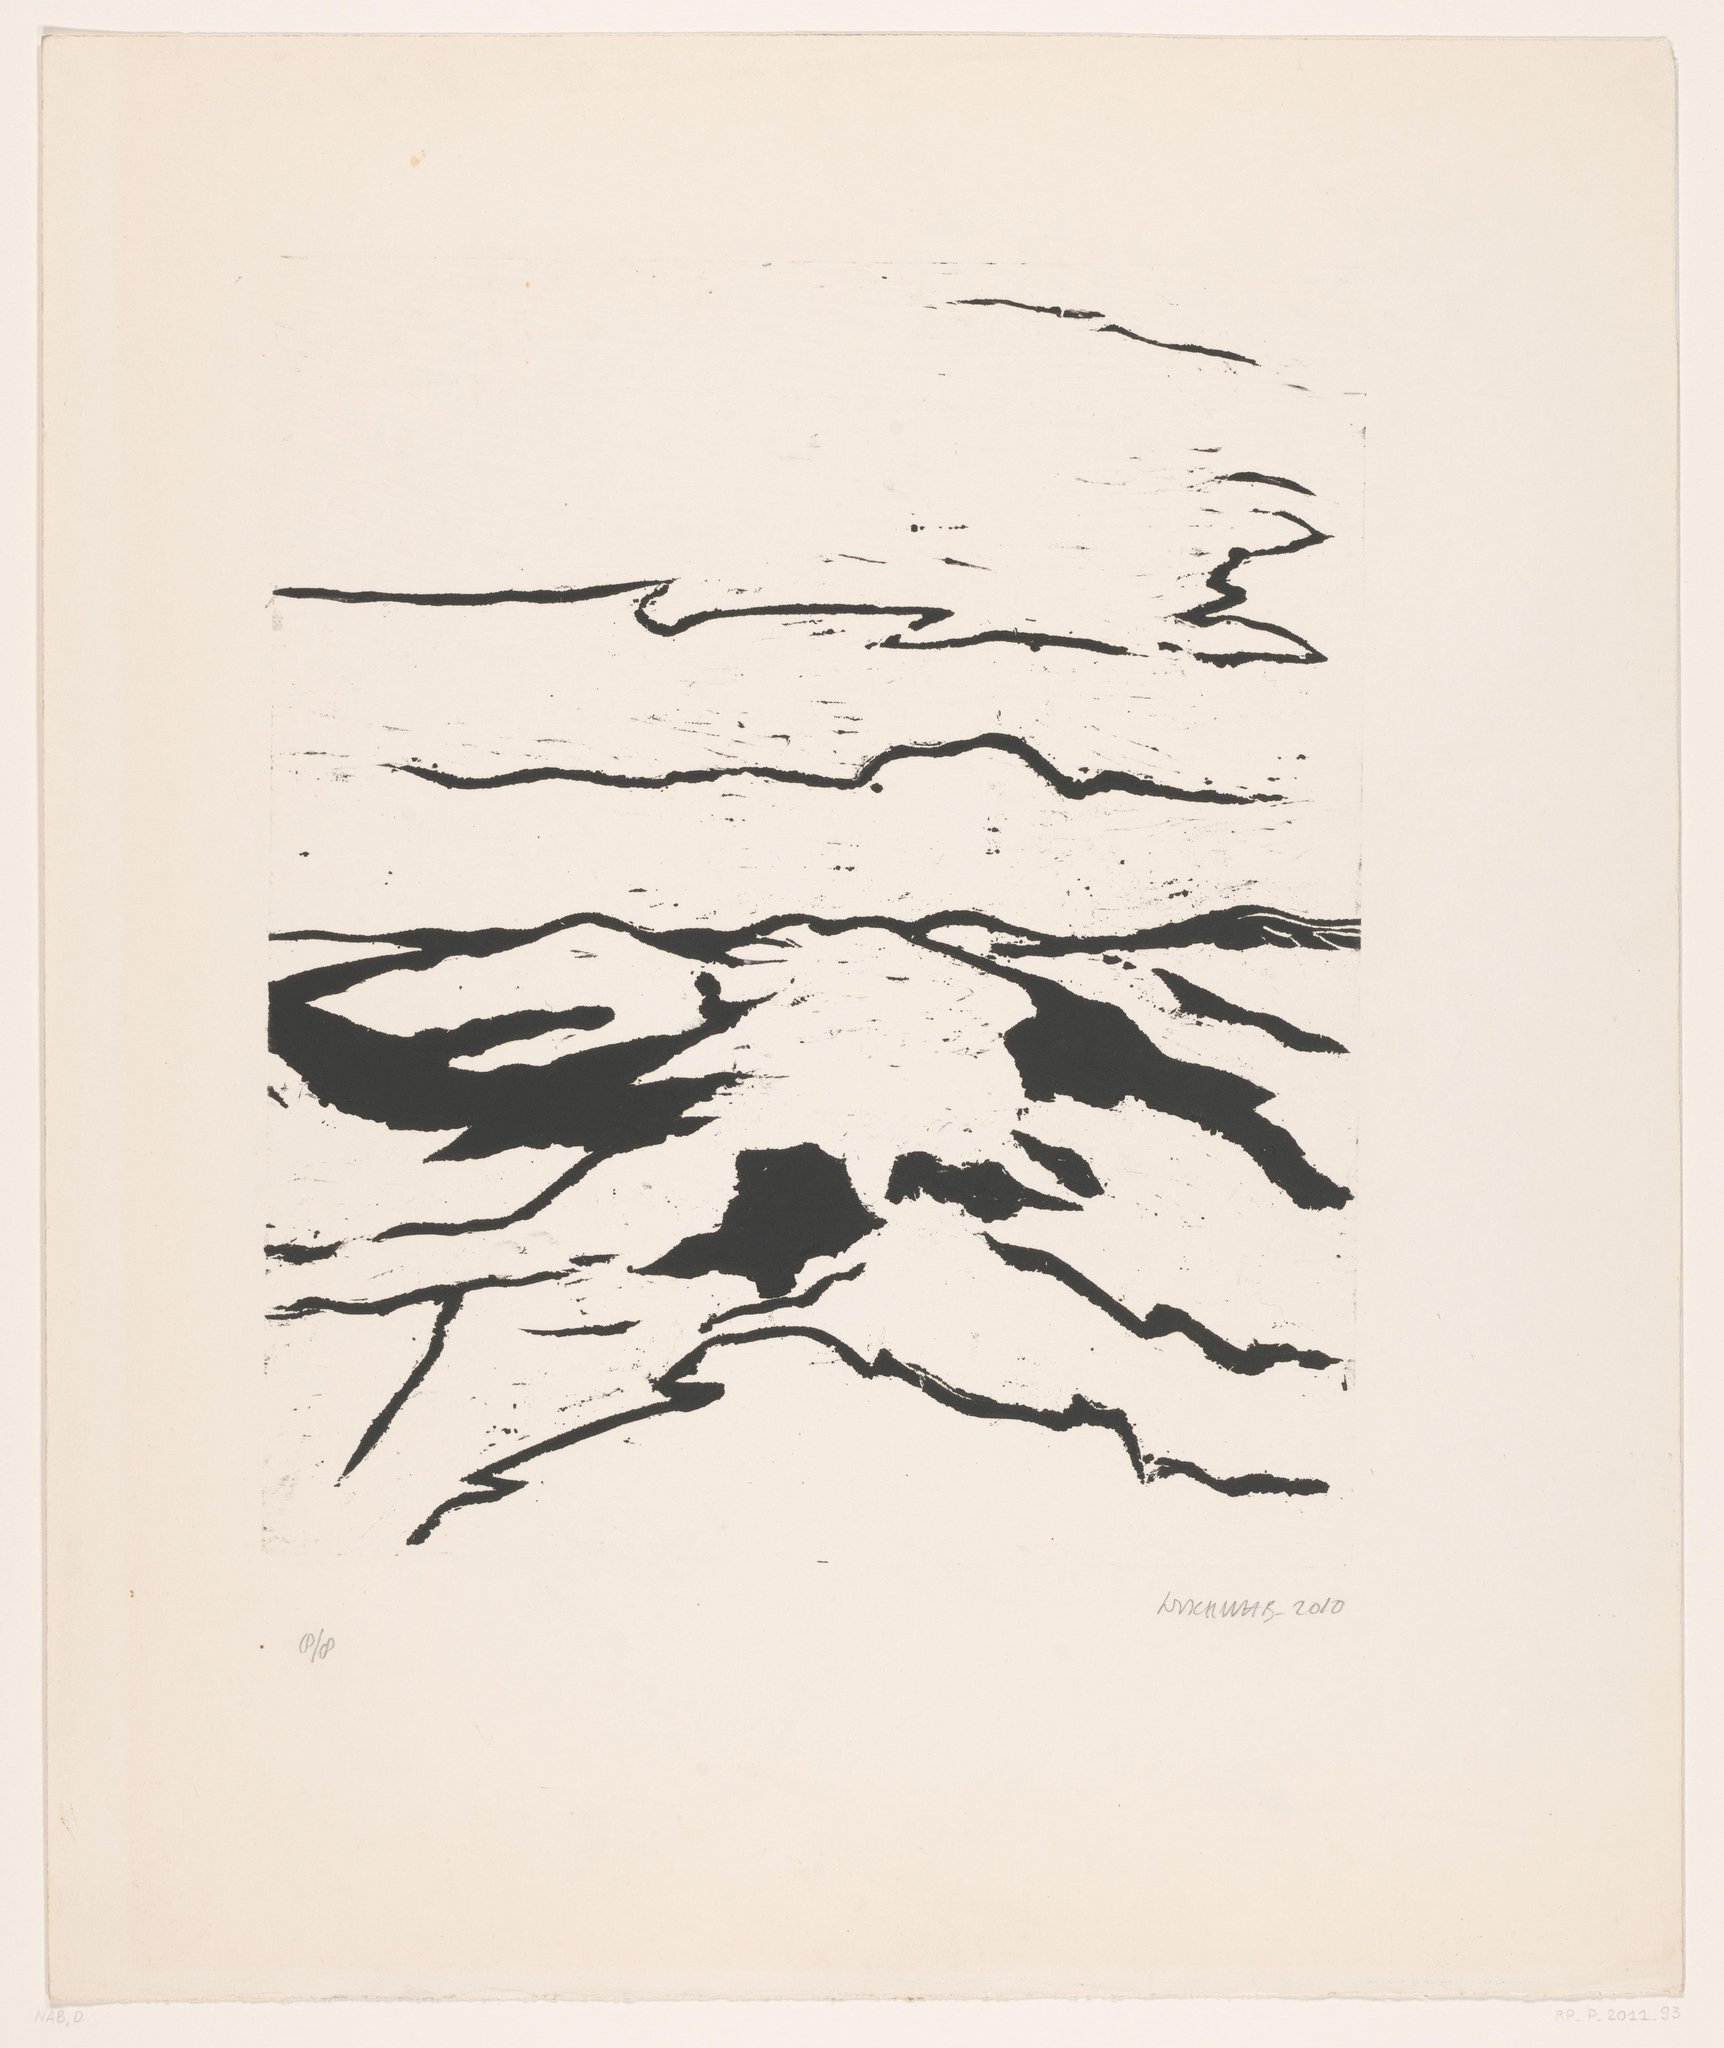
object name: print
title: Duinlandschap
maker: dirck nab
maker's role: draughtsman, painter, print maker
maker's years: 1940-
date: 2010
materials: paper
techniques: blind stamped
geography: bakkum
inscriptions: collector's mark: Lugt 270, collector's mark: Lugt 2228